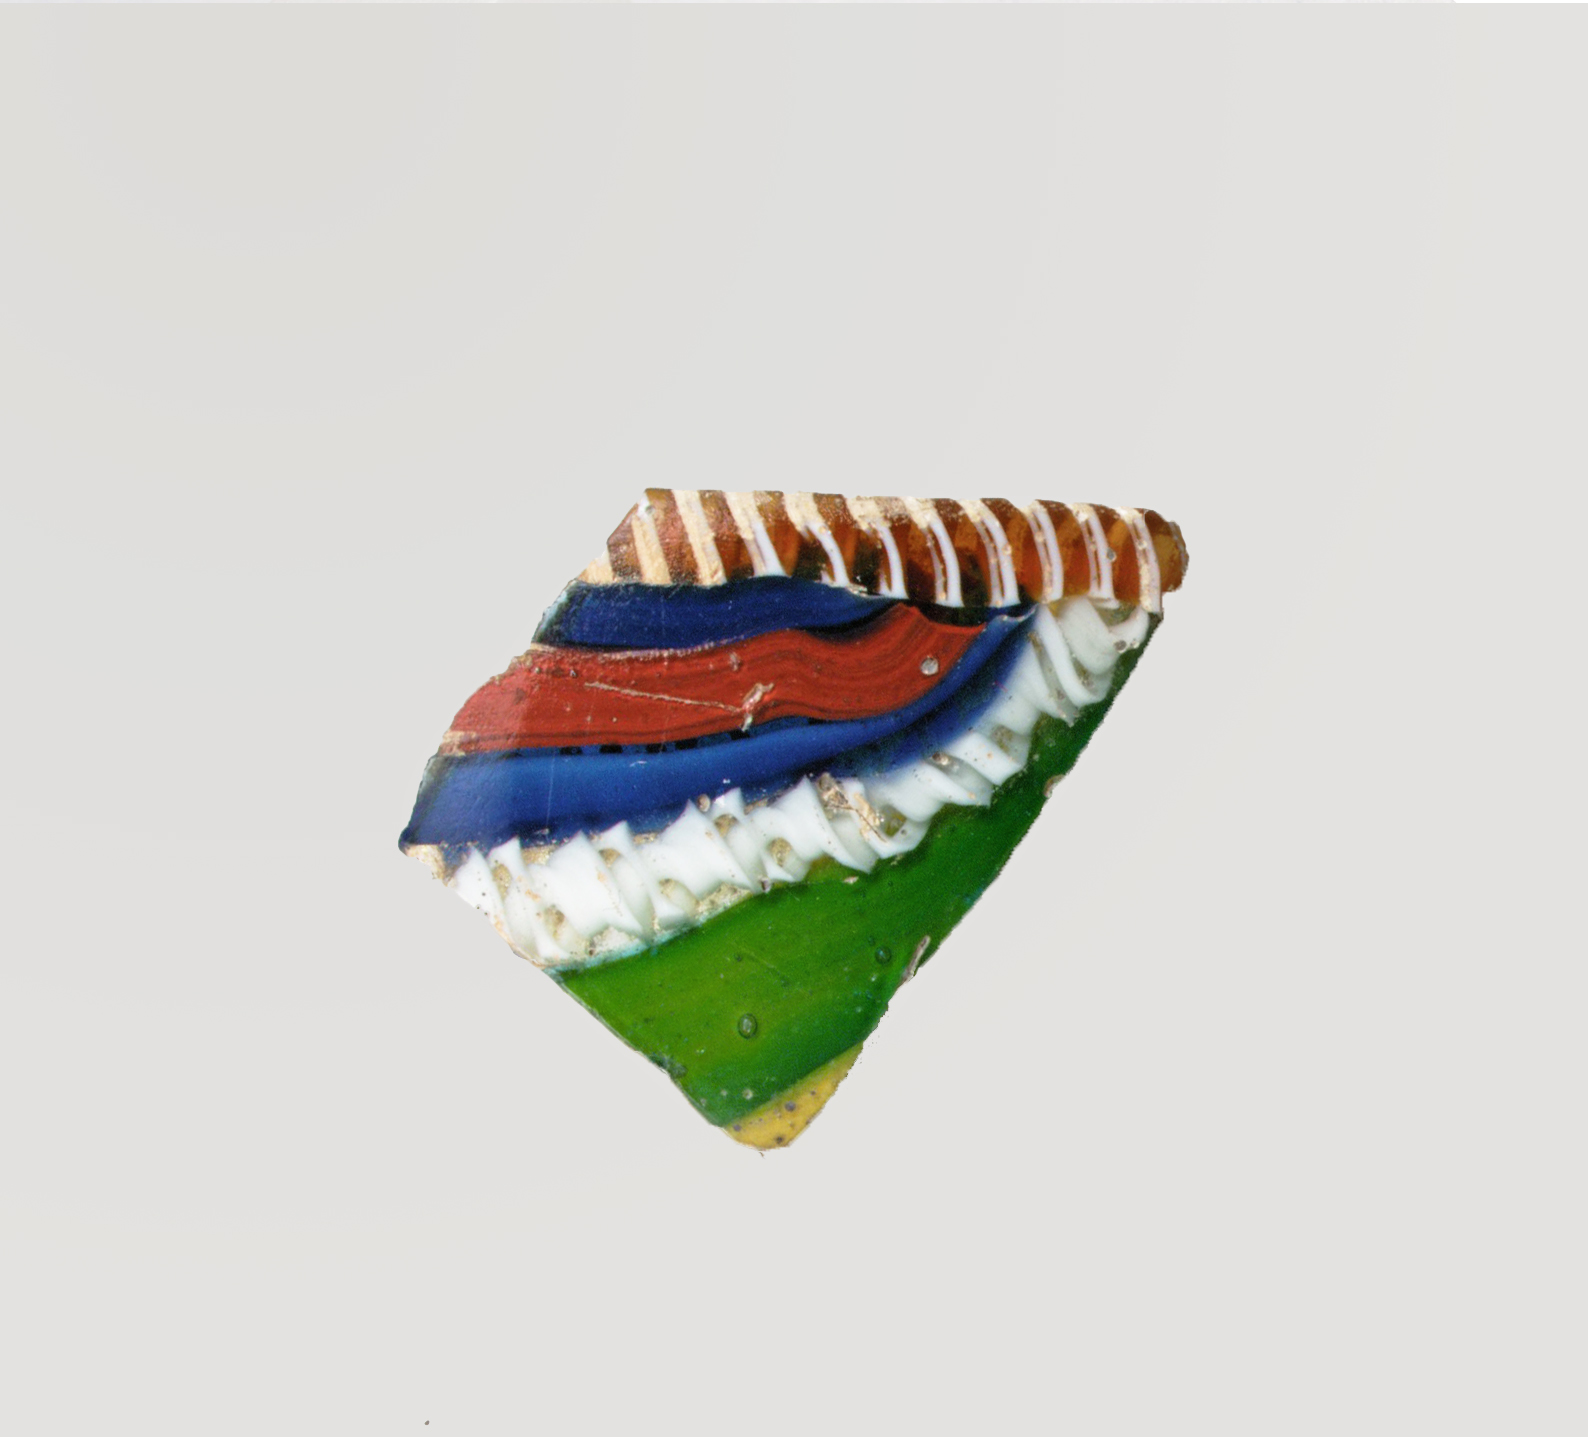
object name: fragment, striped mosaic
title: Glass striped mosaic bowl fragment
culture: roman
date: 34 BCE-33 CE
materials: glass